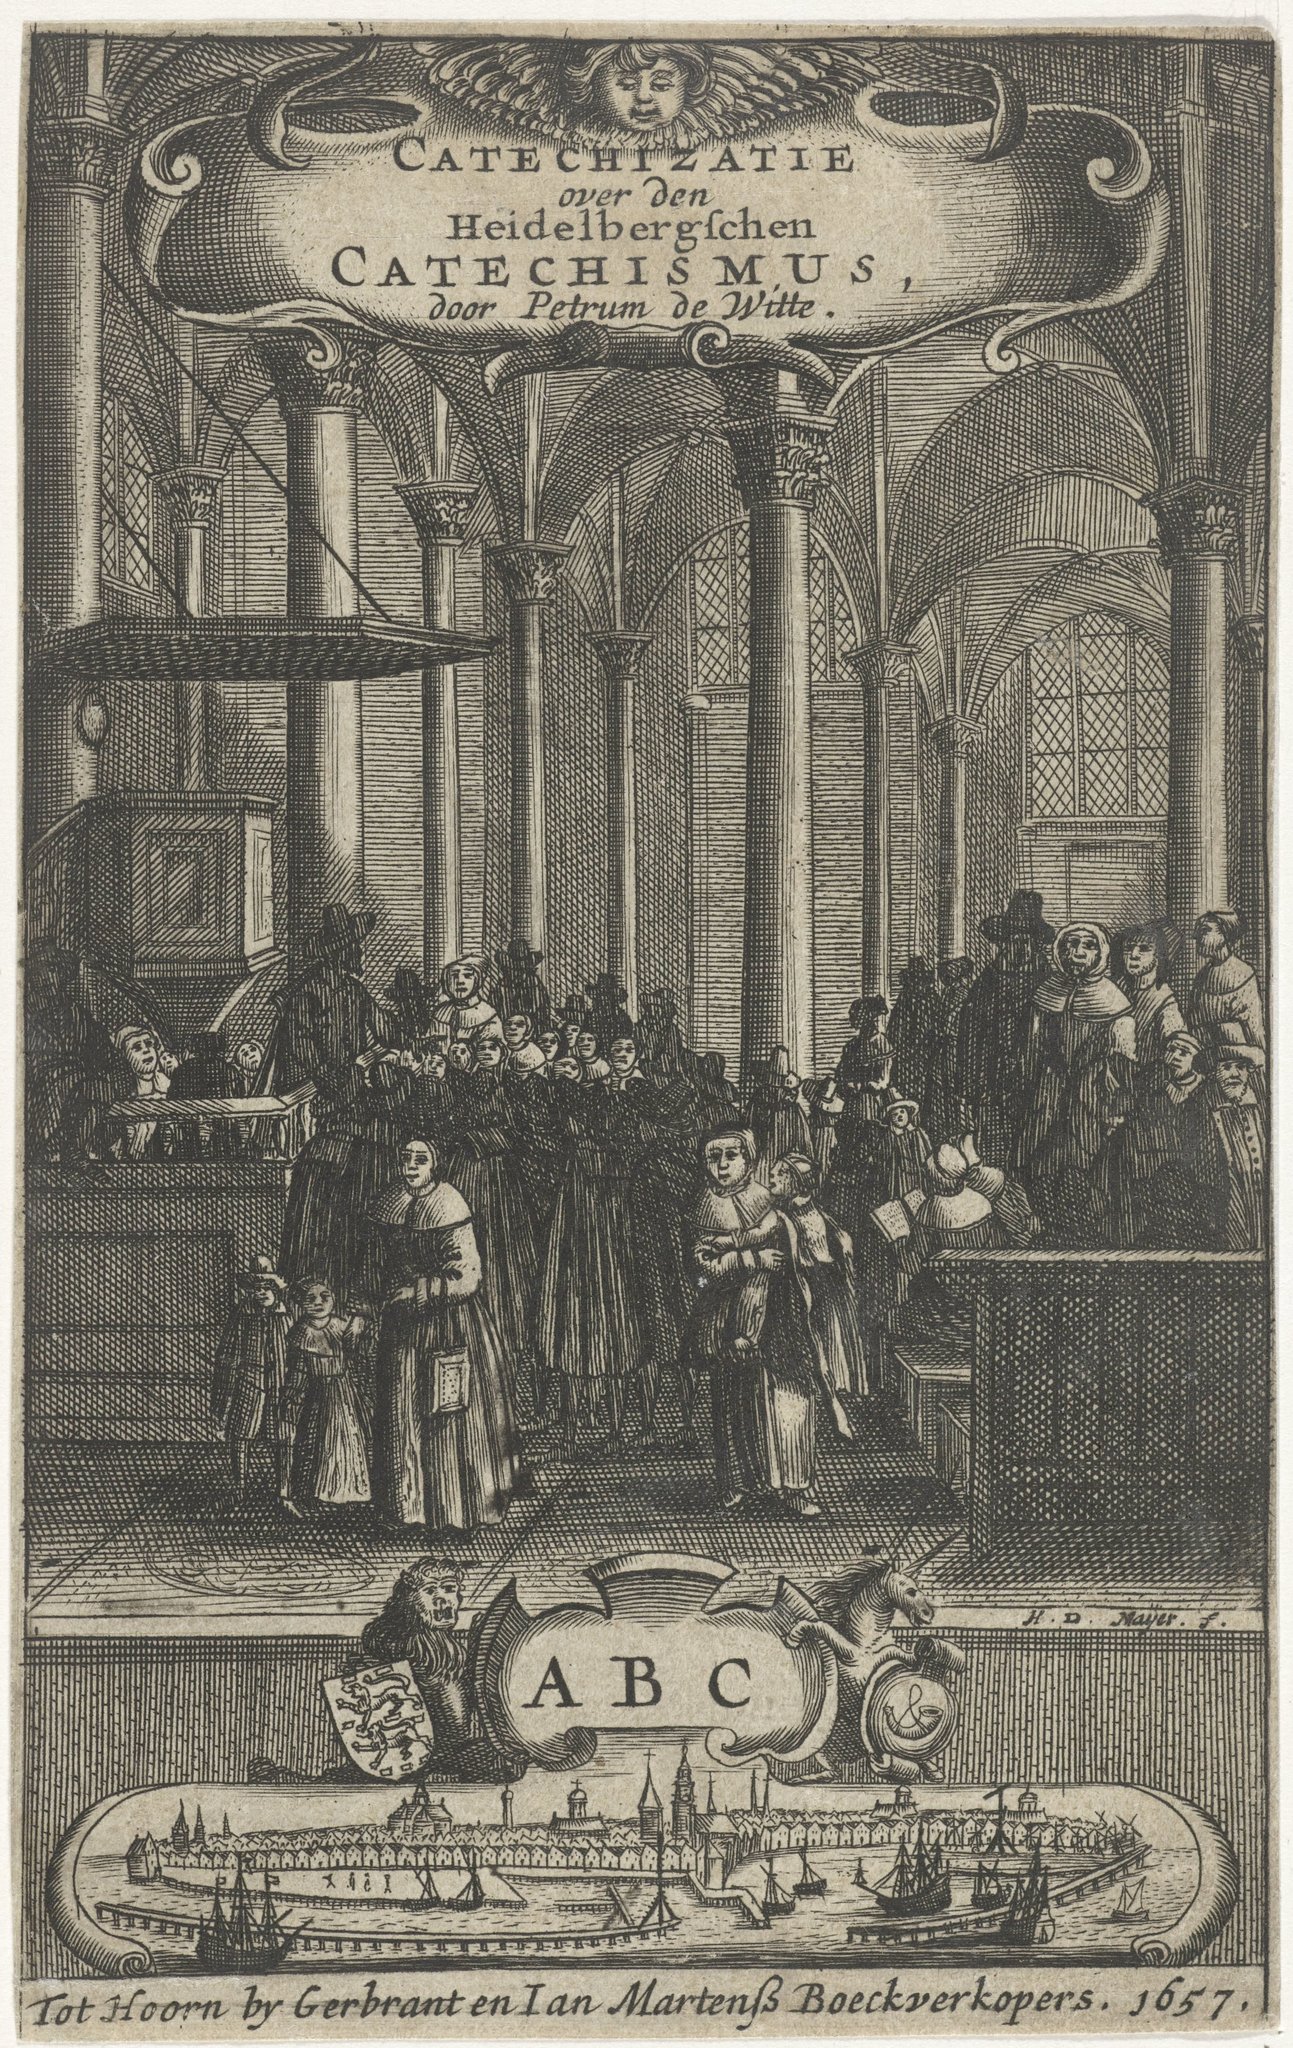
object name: print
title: Titelpagina voor: P. de Witte, Catechizatie over den Heidelbergschen catechismus, 1657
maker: harmen de mayer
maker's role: print maker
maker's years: 1624-1701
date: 1657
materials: paper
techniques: engraving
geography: hoorn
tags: interior of church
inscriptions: collector's mark: Lugt 2228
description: Interieur van een kerk met een menigte mensen. Links de preekstoel. Midden onder een cartouche met een gezicht op een havenstad.